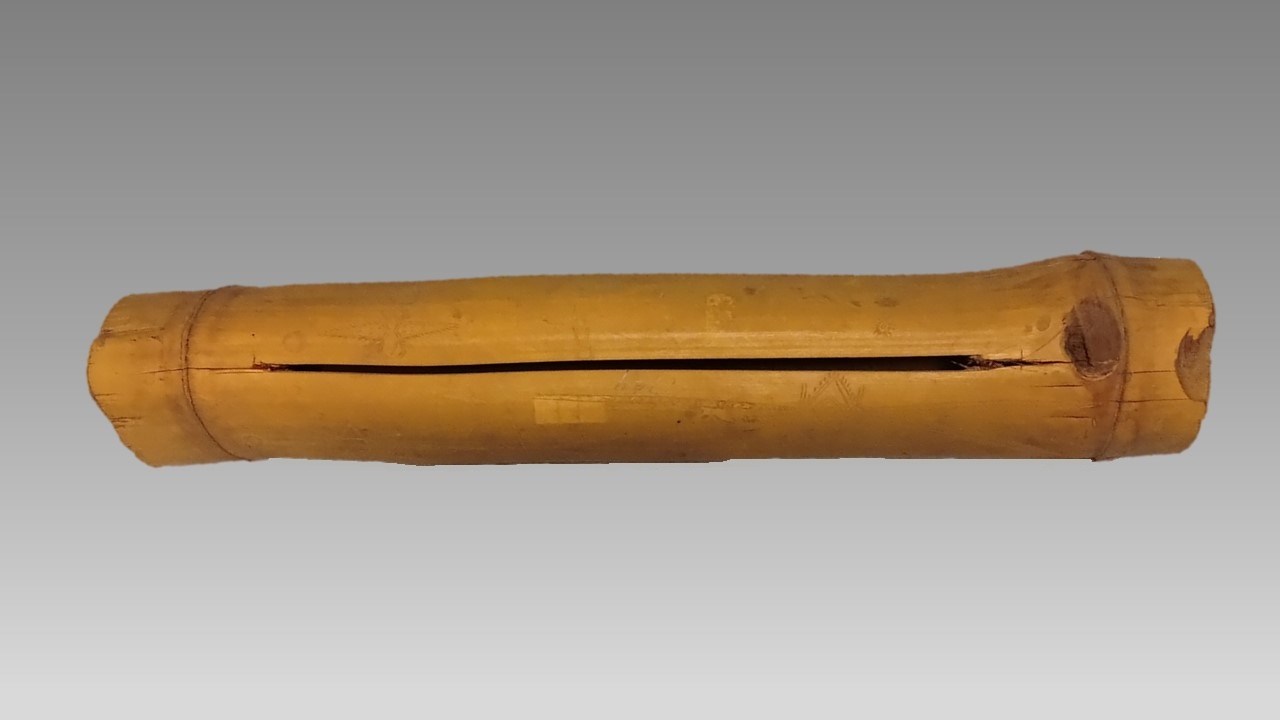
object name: kove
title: Kove (slit drum)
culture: melanesian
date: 1867-1900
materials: bamboo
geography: vanuatu